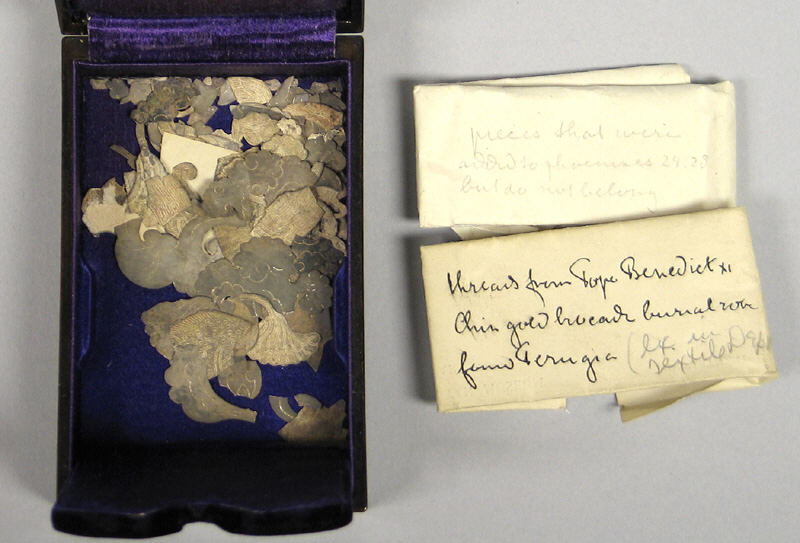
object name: box of remnant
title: Box of Remnants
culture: chinese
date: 618-907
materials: silver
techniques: inlay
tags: flowers